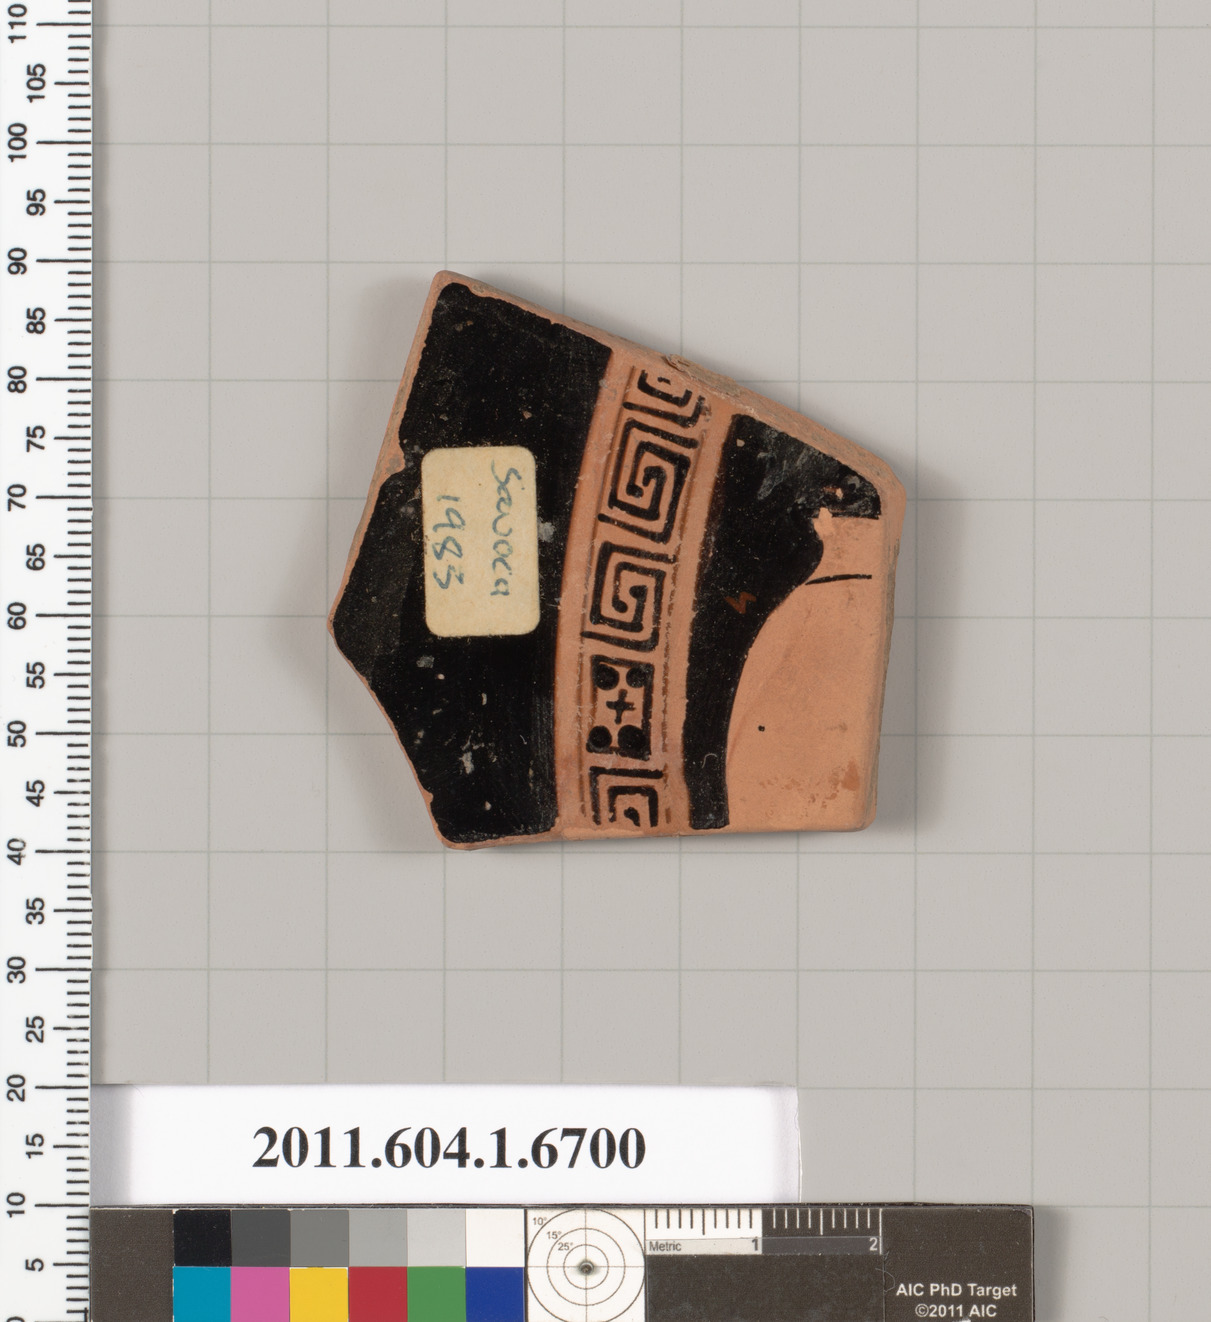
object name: kylix fragment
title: Terracotta fragment of a kylix (drinking cup)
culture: greek, attic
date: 490-470 BCE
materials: terracotta